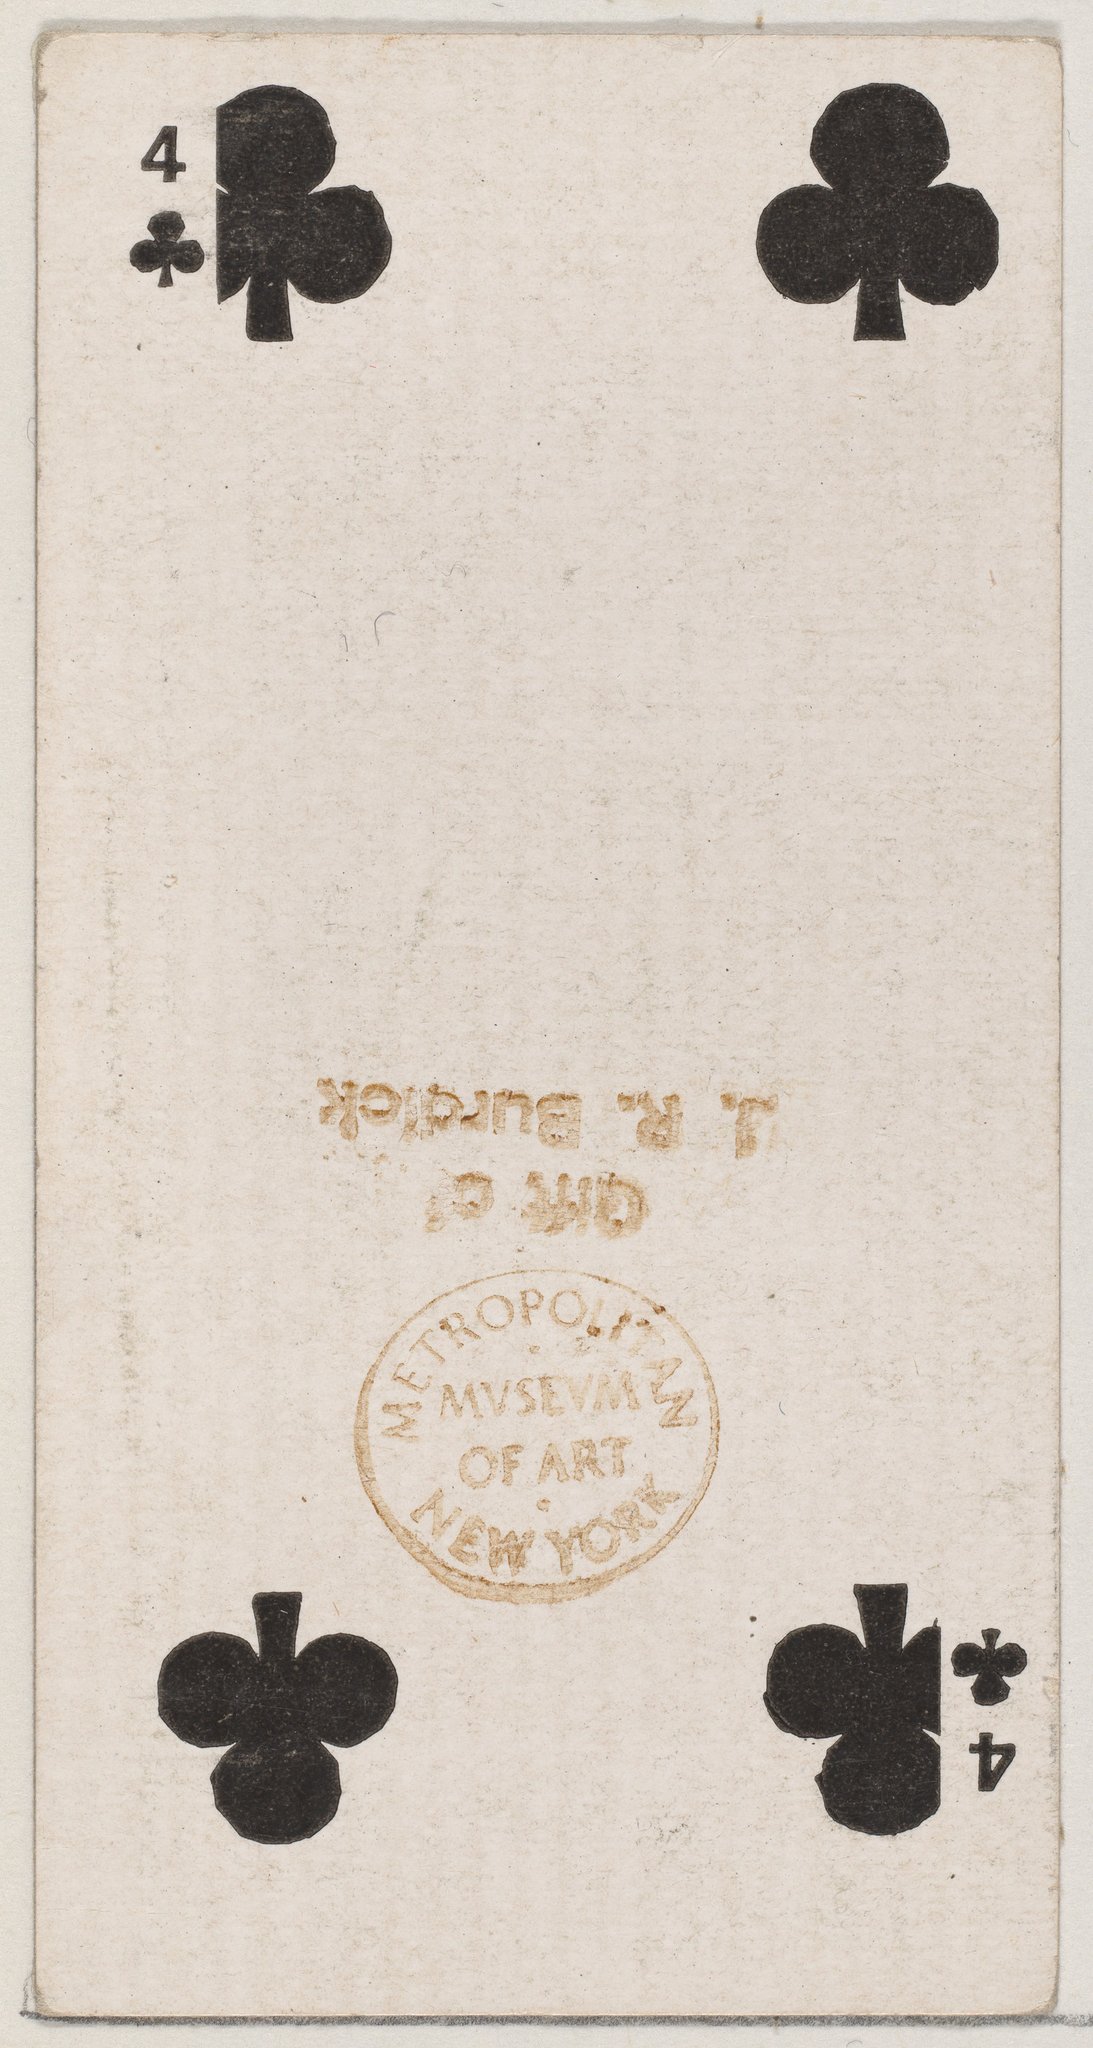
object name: print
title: Four Clubs (black), from the Playing Cards series (N84) for Duke brand cigarettes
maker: w. duke, sons & co.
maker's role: publisher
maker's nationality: american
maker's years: 1870-1920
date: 1888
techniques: color lithograph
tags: playing cards